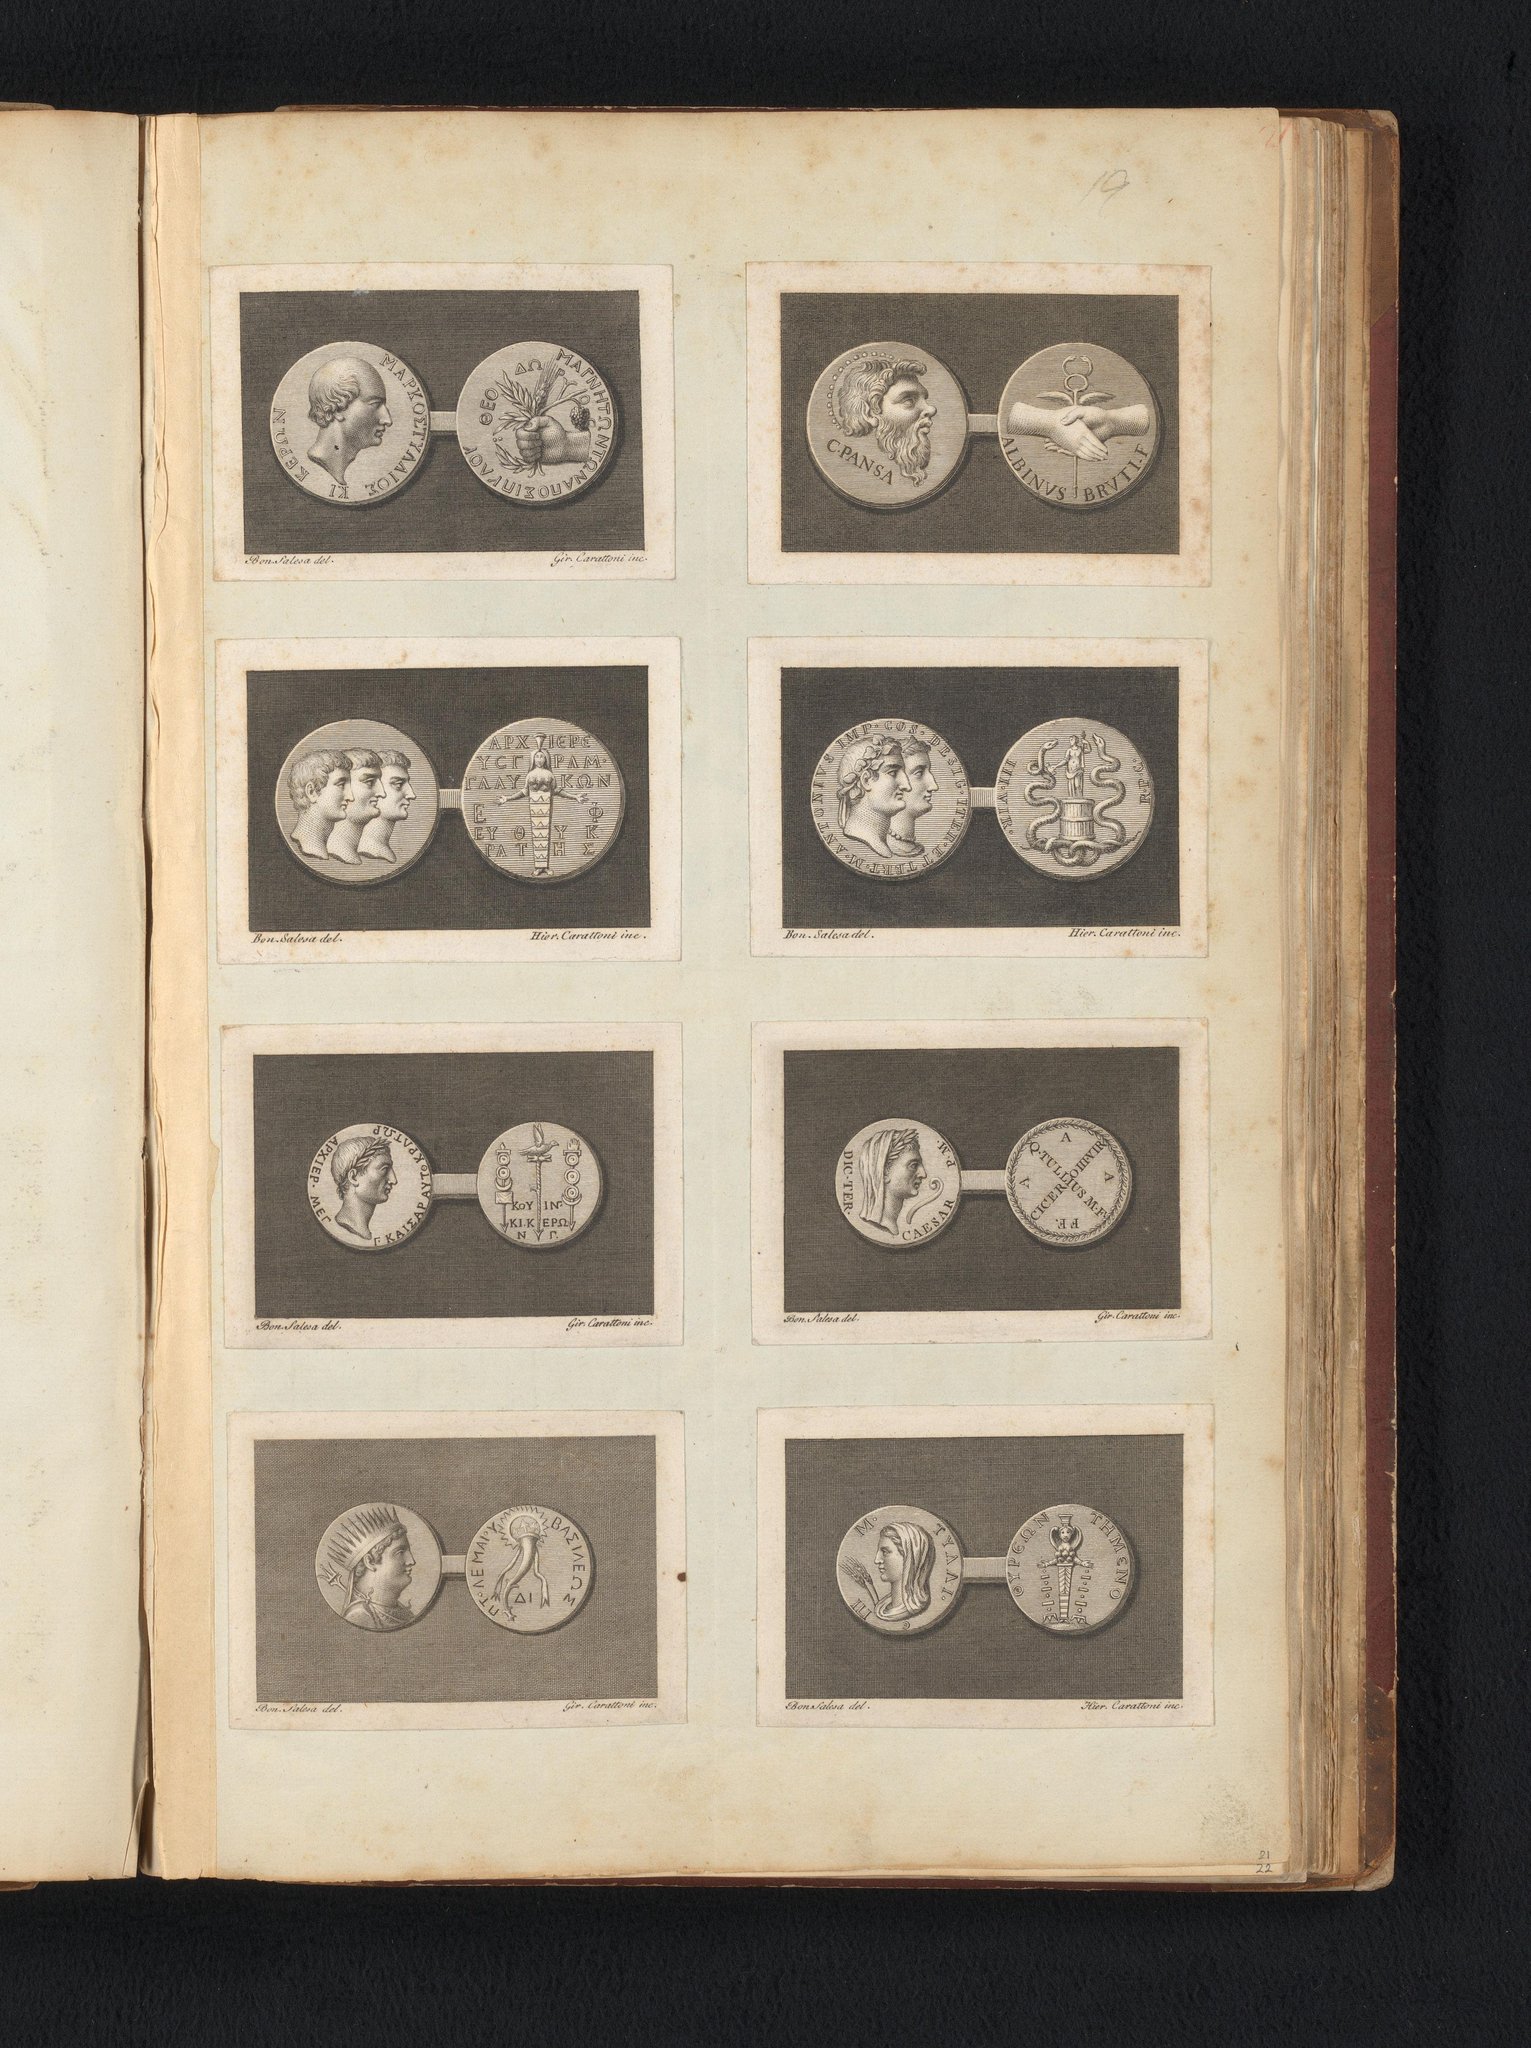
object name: album leaf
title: Antieke munten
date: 1750-1816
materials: paper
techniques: engraving, etching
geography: italy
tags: coin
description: Acht antieke munten, beide zijden. Onderdeel van het tweede van twee albums met ingeplakte prenten en tekeningen te dienen als tekenvoorbeelden.